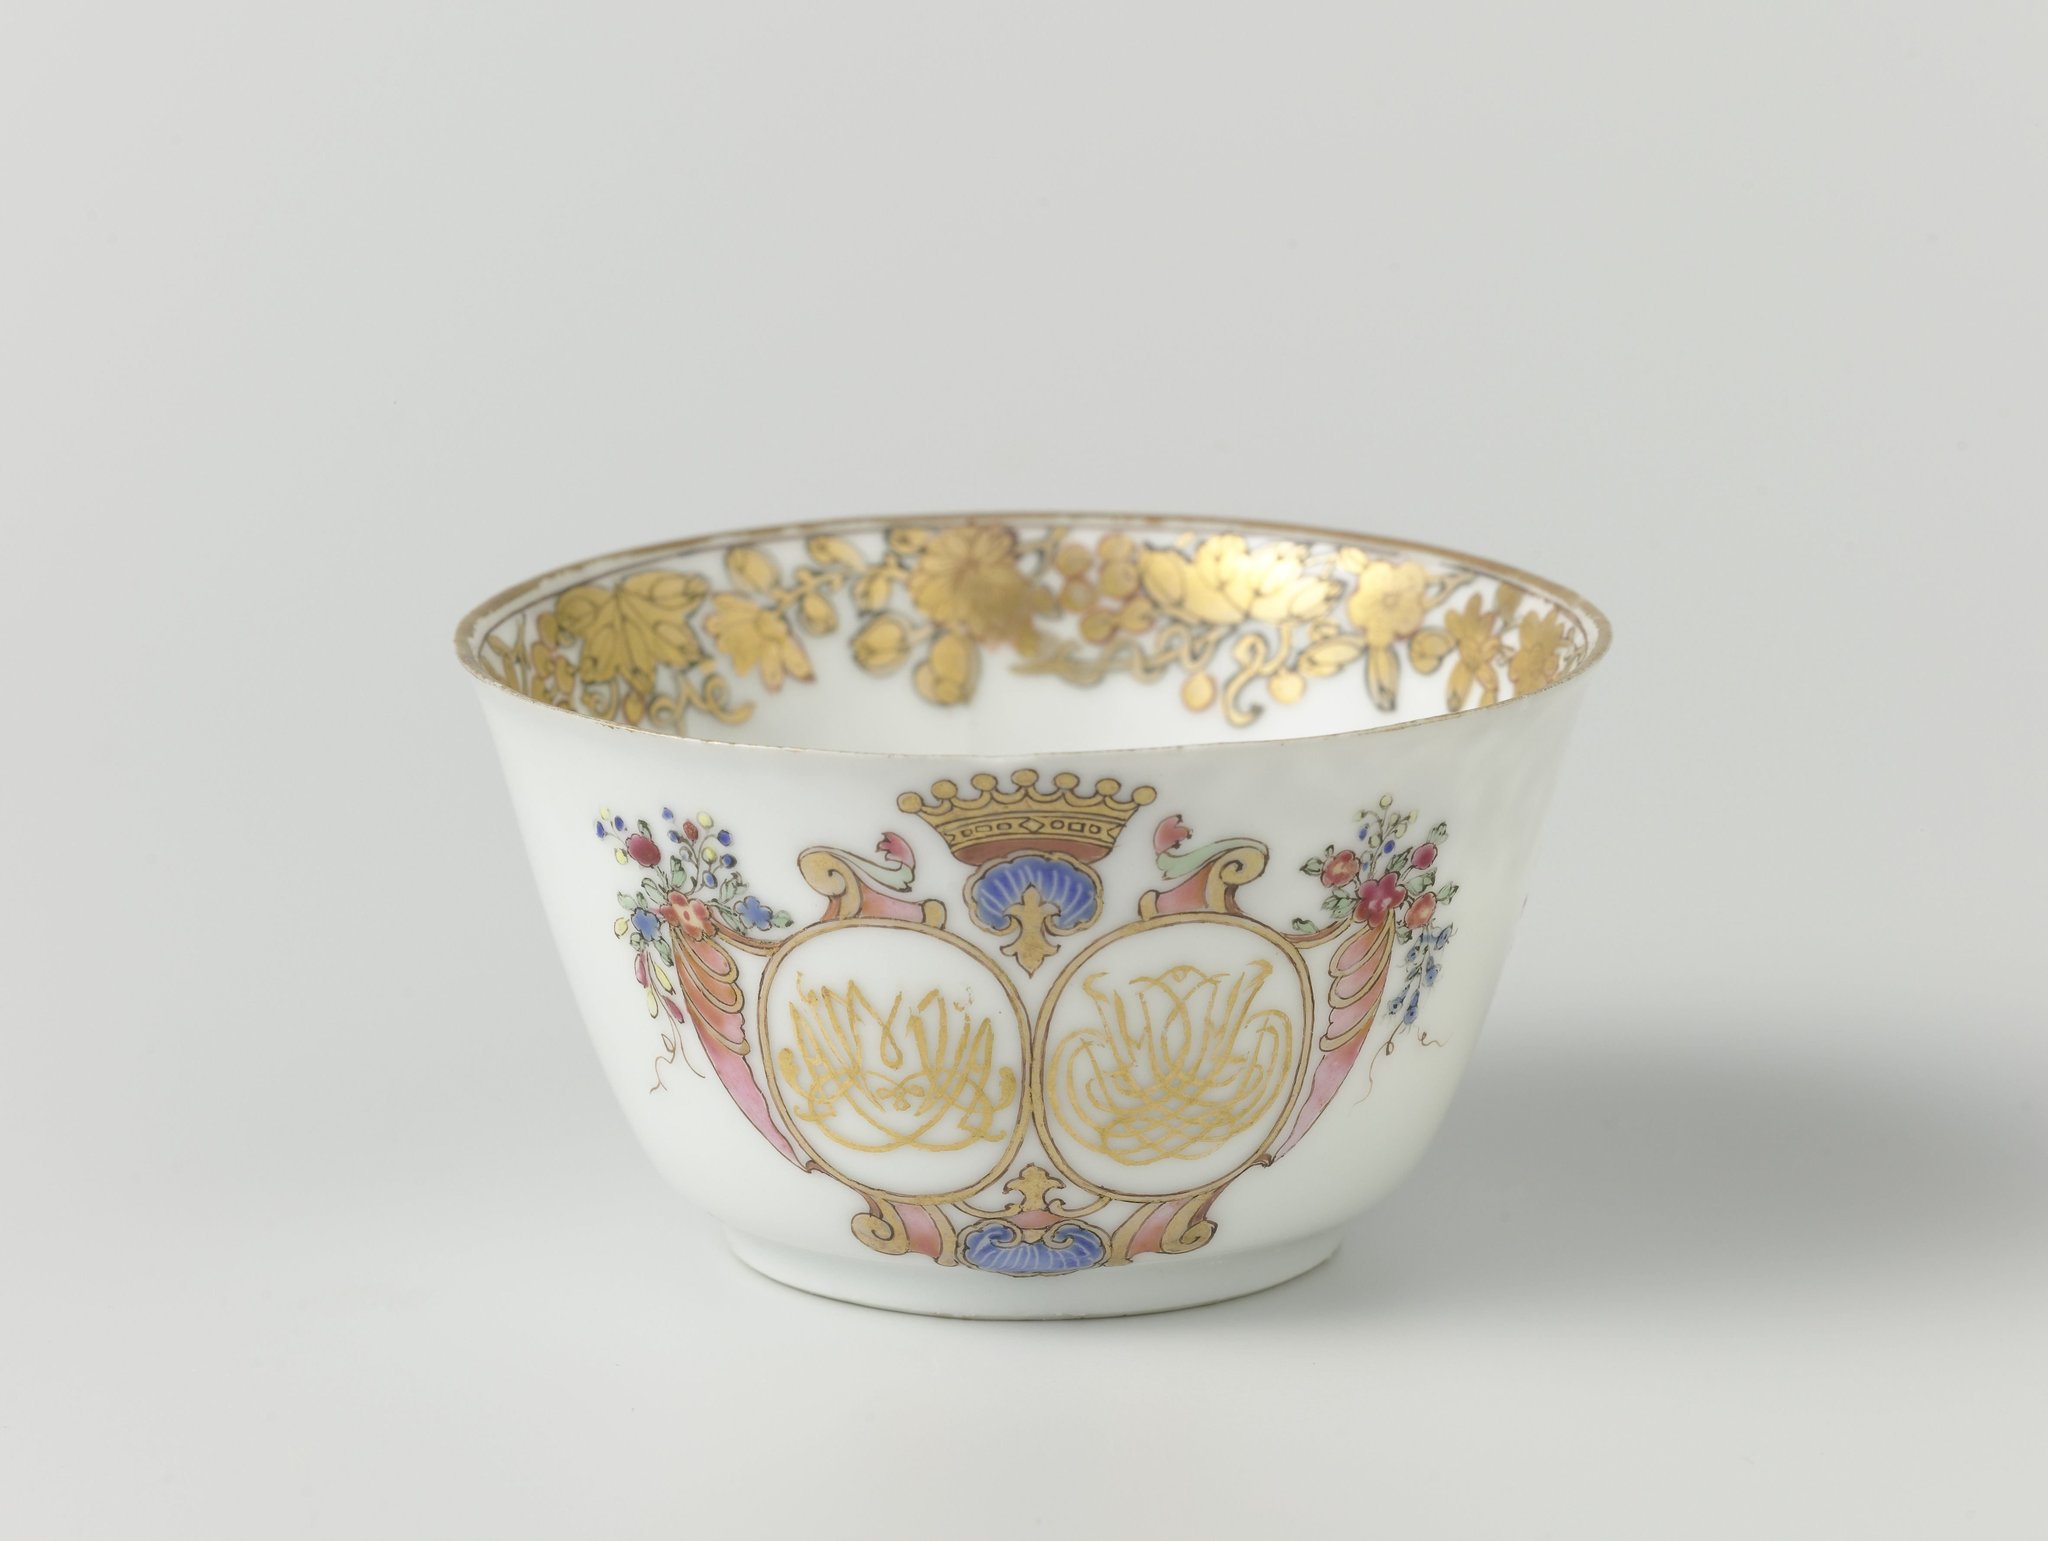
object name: tea cup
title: Bell-shaped cup from the 'Swellengrebel service' with a double crowned monogram and a border with floral scrolls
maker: Anonymous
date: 1740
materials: glaze, gold, paint, porcelain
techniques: firing, gilding, turning, vitrification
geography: china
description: De monogrammen 'MVA' en 'CHTD' staan voor Maurits van Aerden (1694-1746) en Constantia Helena ten Damme (1694-1772), getrouwd in 1716. Het servies is waarschijnlijk besteld ter ere van hun vijfentwingtigjarig huwelijksjubileum in 1741. (Campen, Jan van & Hartkamp-Jonxis, Ebeltje, Aziatische weelde : VOC-kunst in het Rijksmuseum, Zutphen 2011, p. 78)